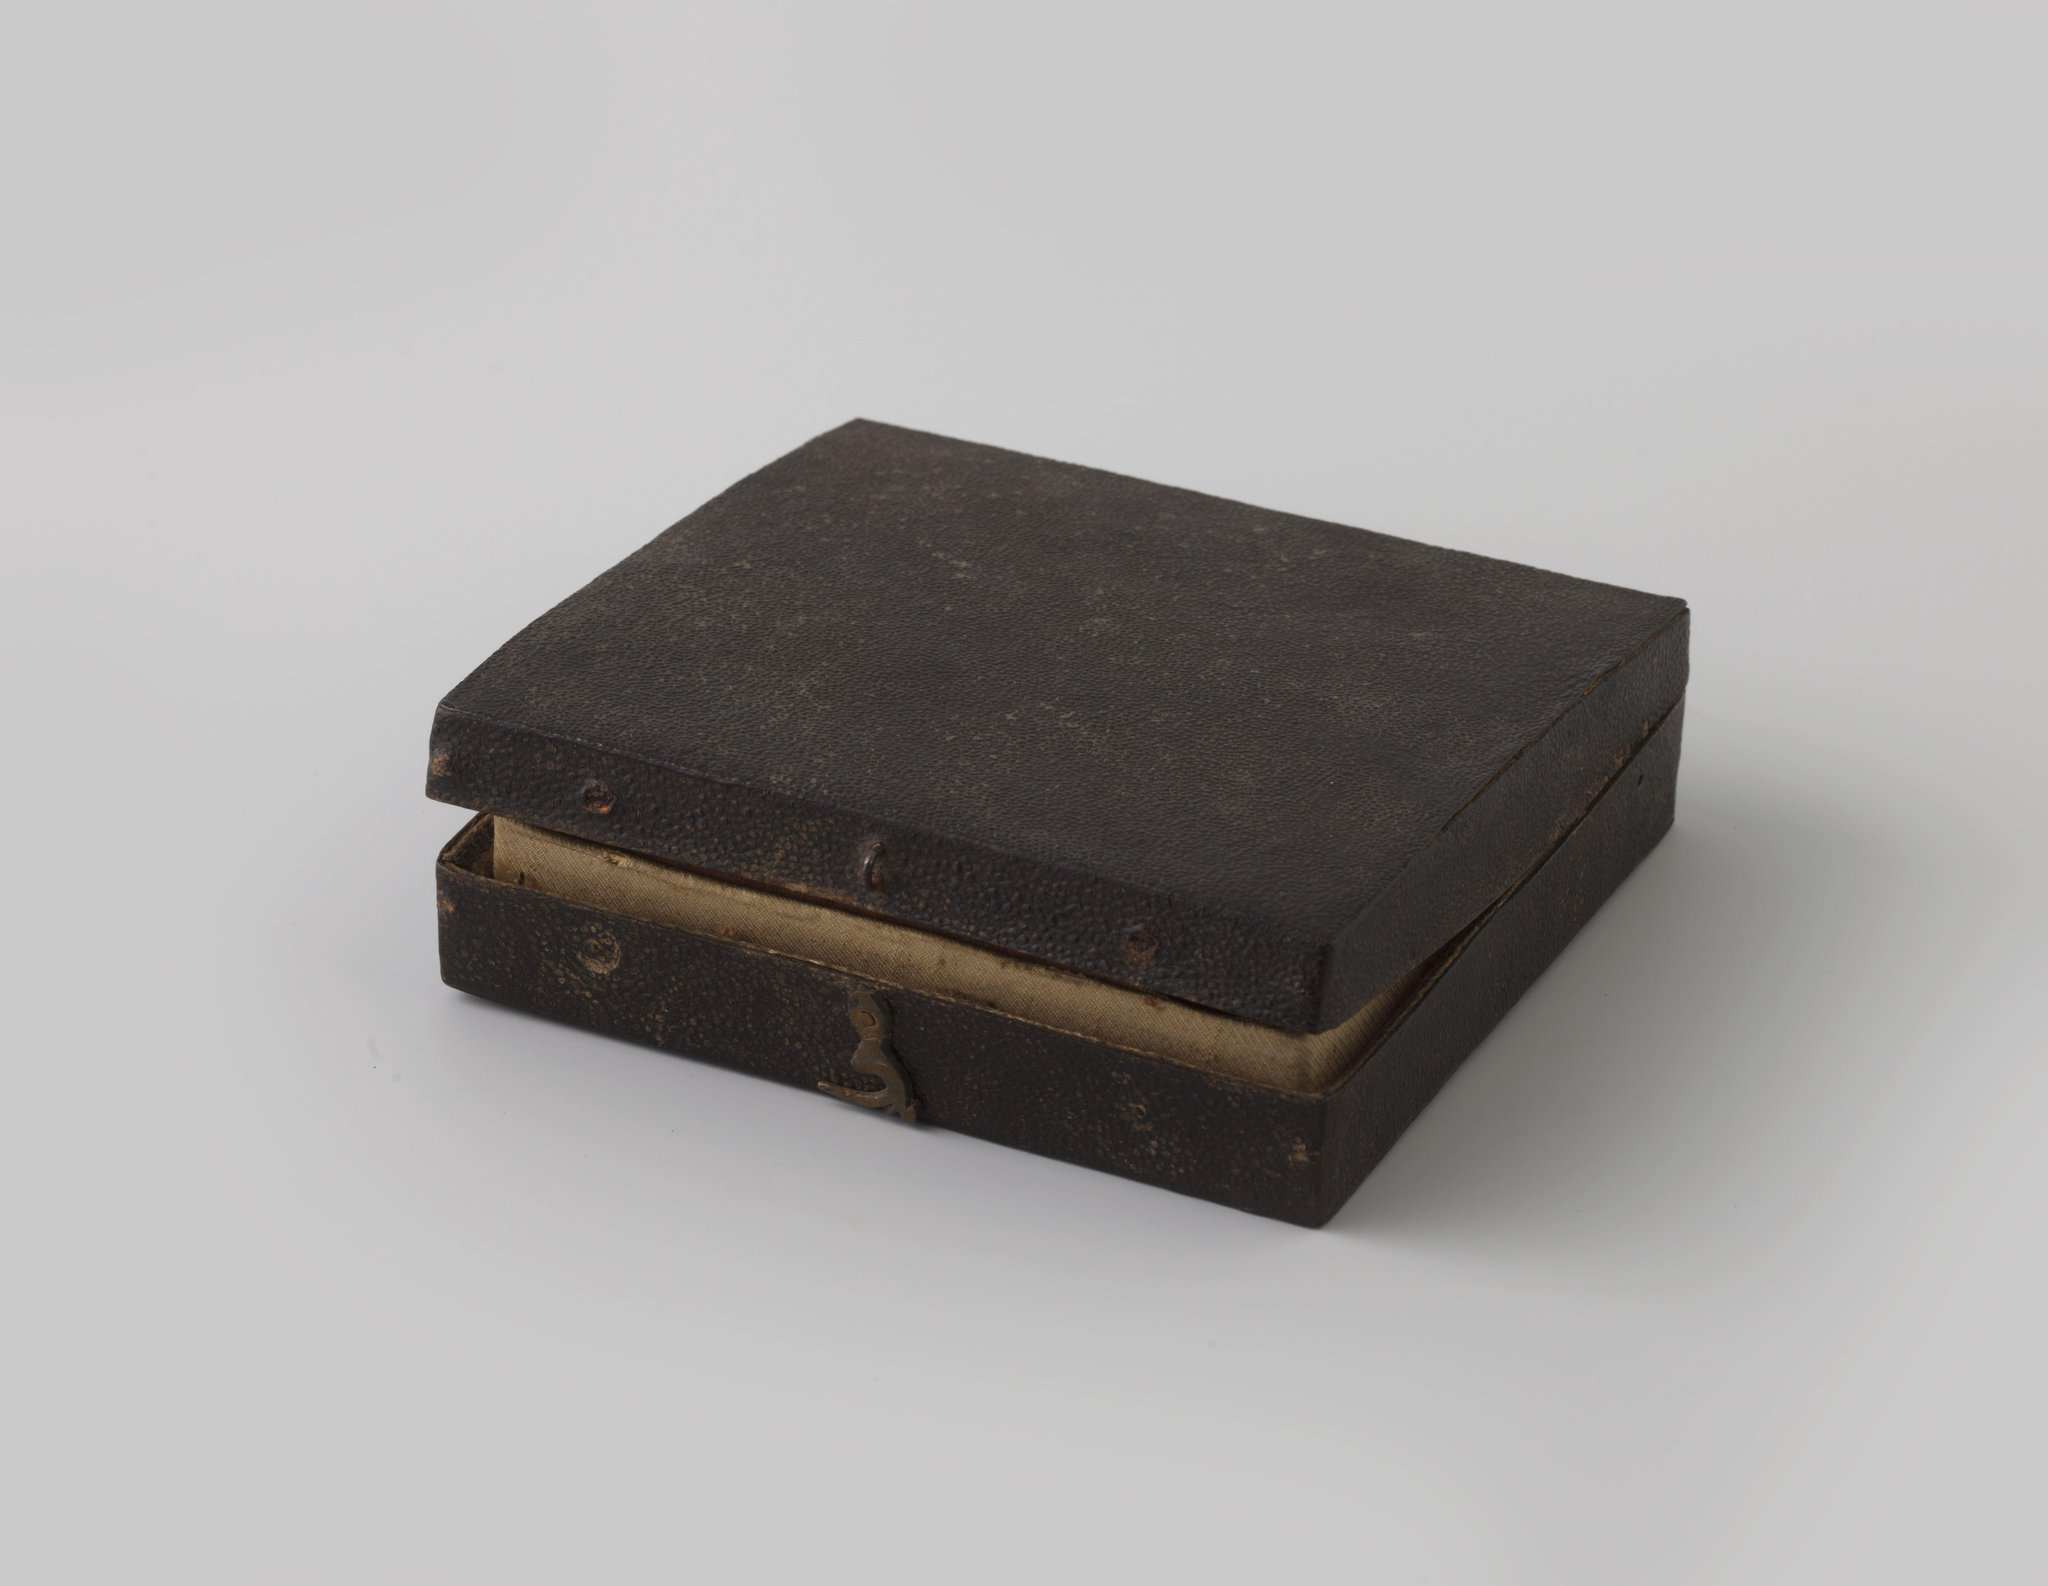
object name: étui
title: Zwarte vierkante juwelendoos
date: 1824-1838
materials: gold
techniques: filigree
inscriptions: maker's mark: ‘PC waartussen een anker in zeshoek’, alloy mark: ‘leeuwenkop naar links (Nederland 1813-1906)’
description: Zwarte vierkante juwelendoos voor twee oorhangers.